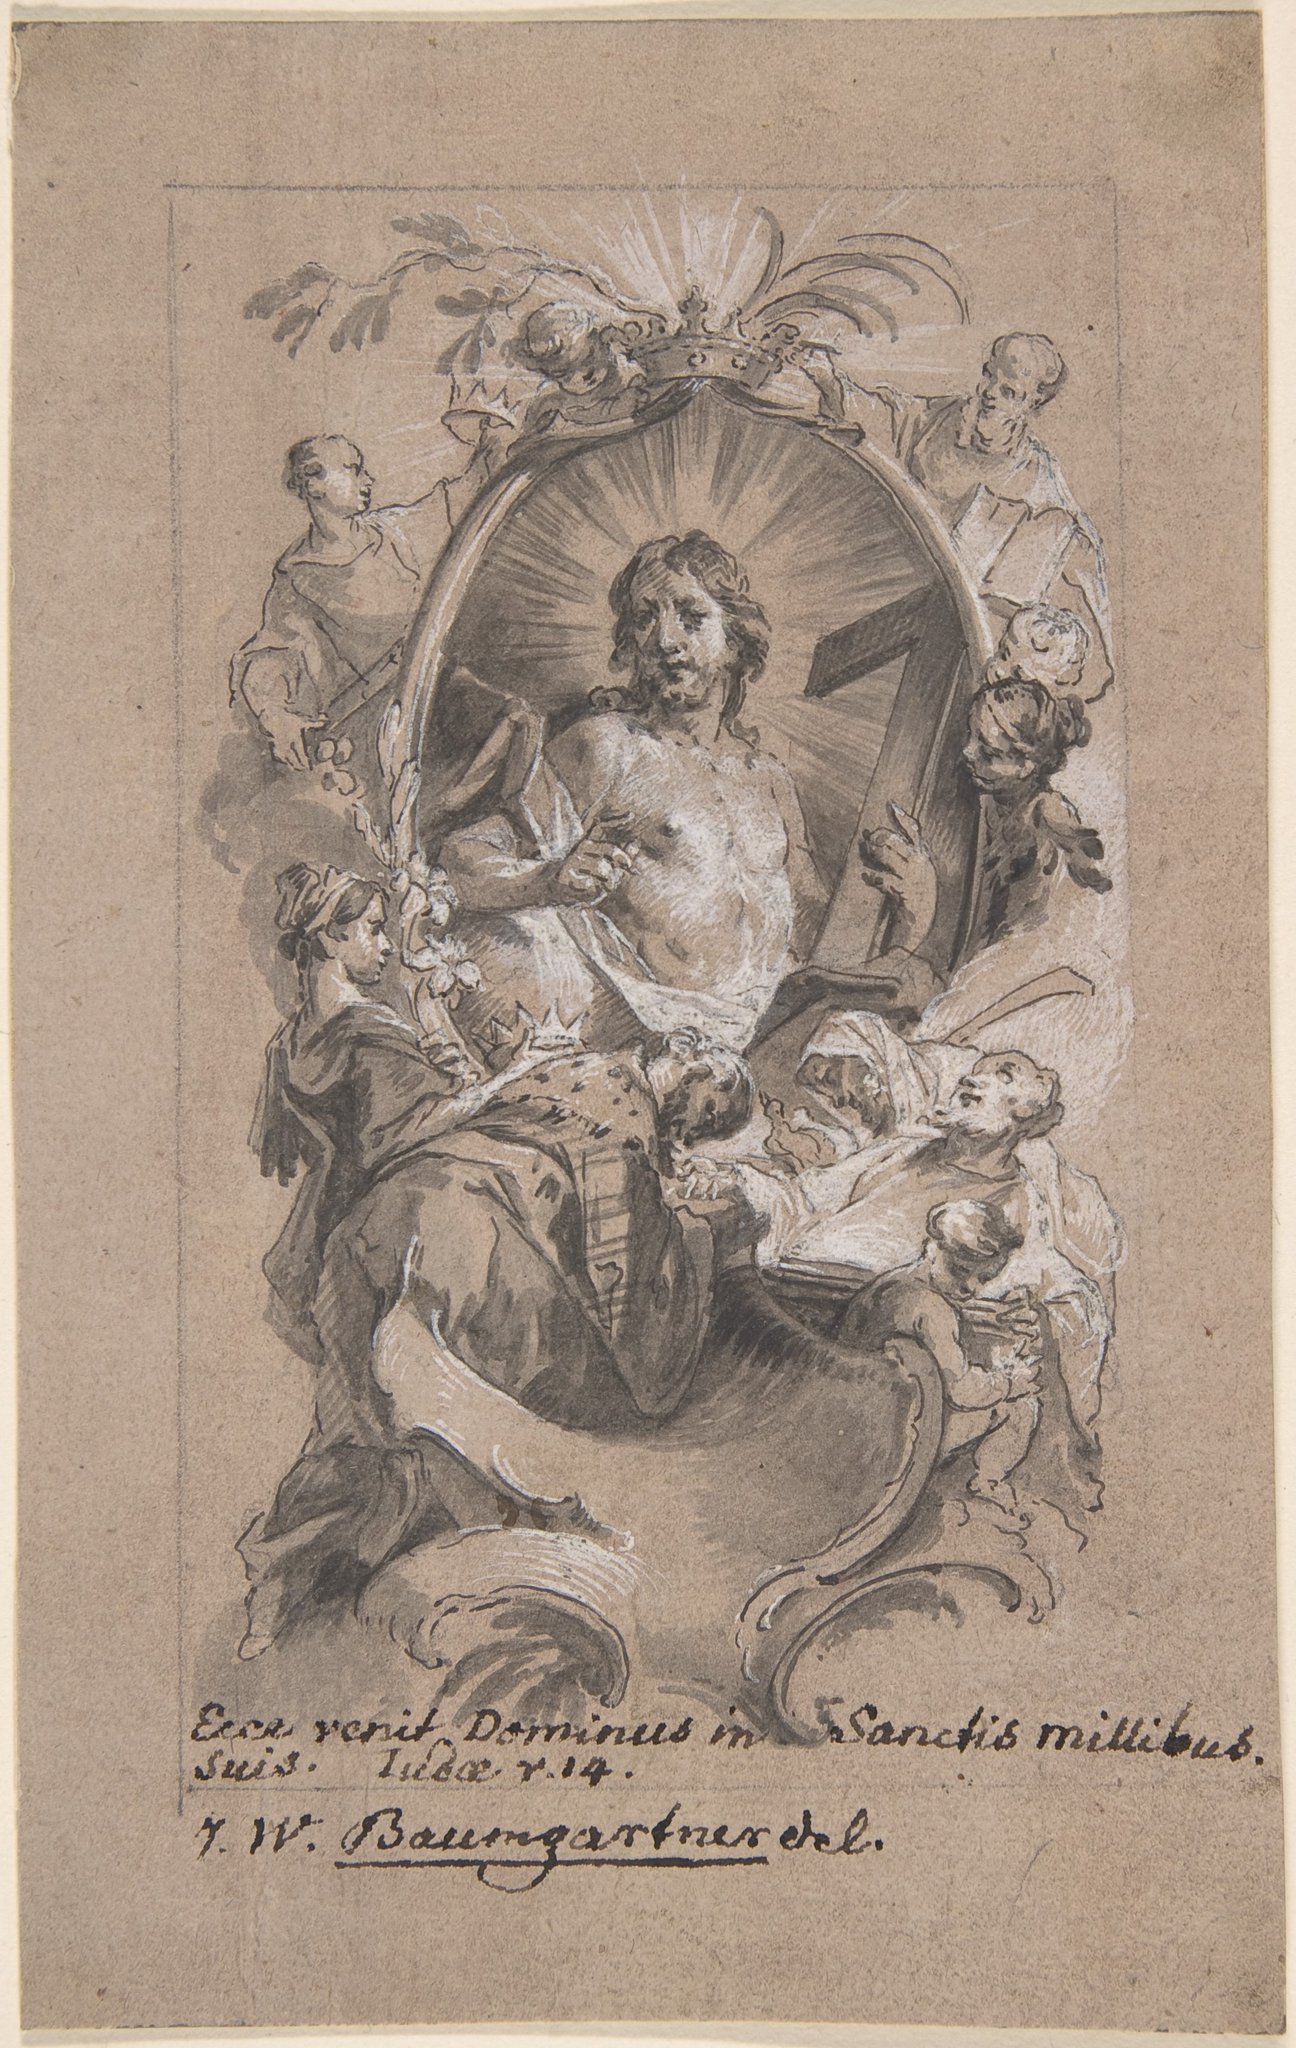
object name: drawing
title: Christ in Glory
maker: johann wolfgang baumgartner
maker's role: artist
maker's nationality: german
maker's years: 1712-1761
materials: chalk, ink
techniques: brush, heightening, pen, wash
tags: men,women,christ,cross